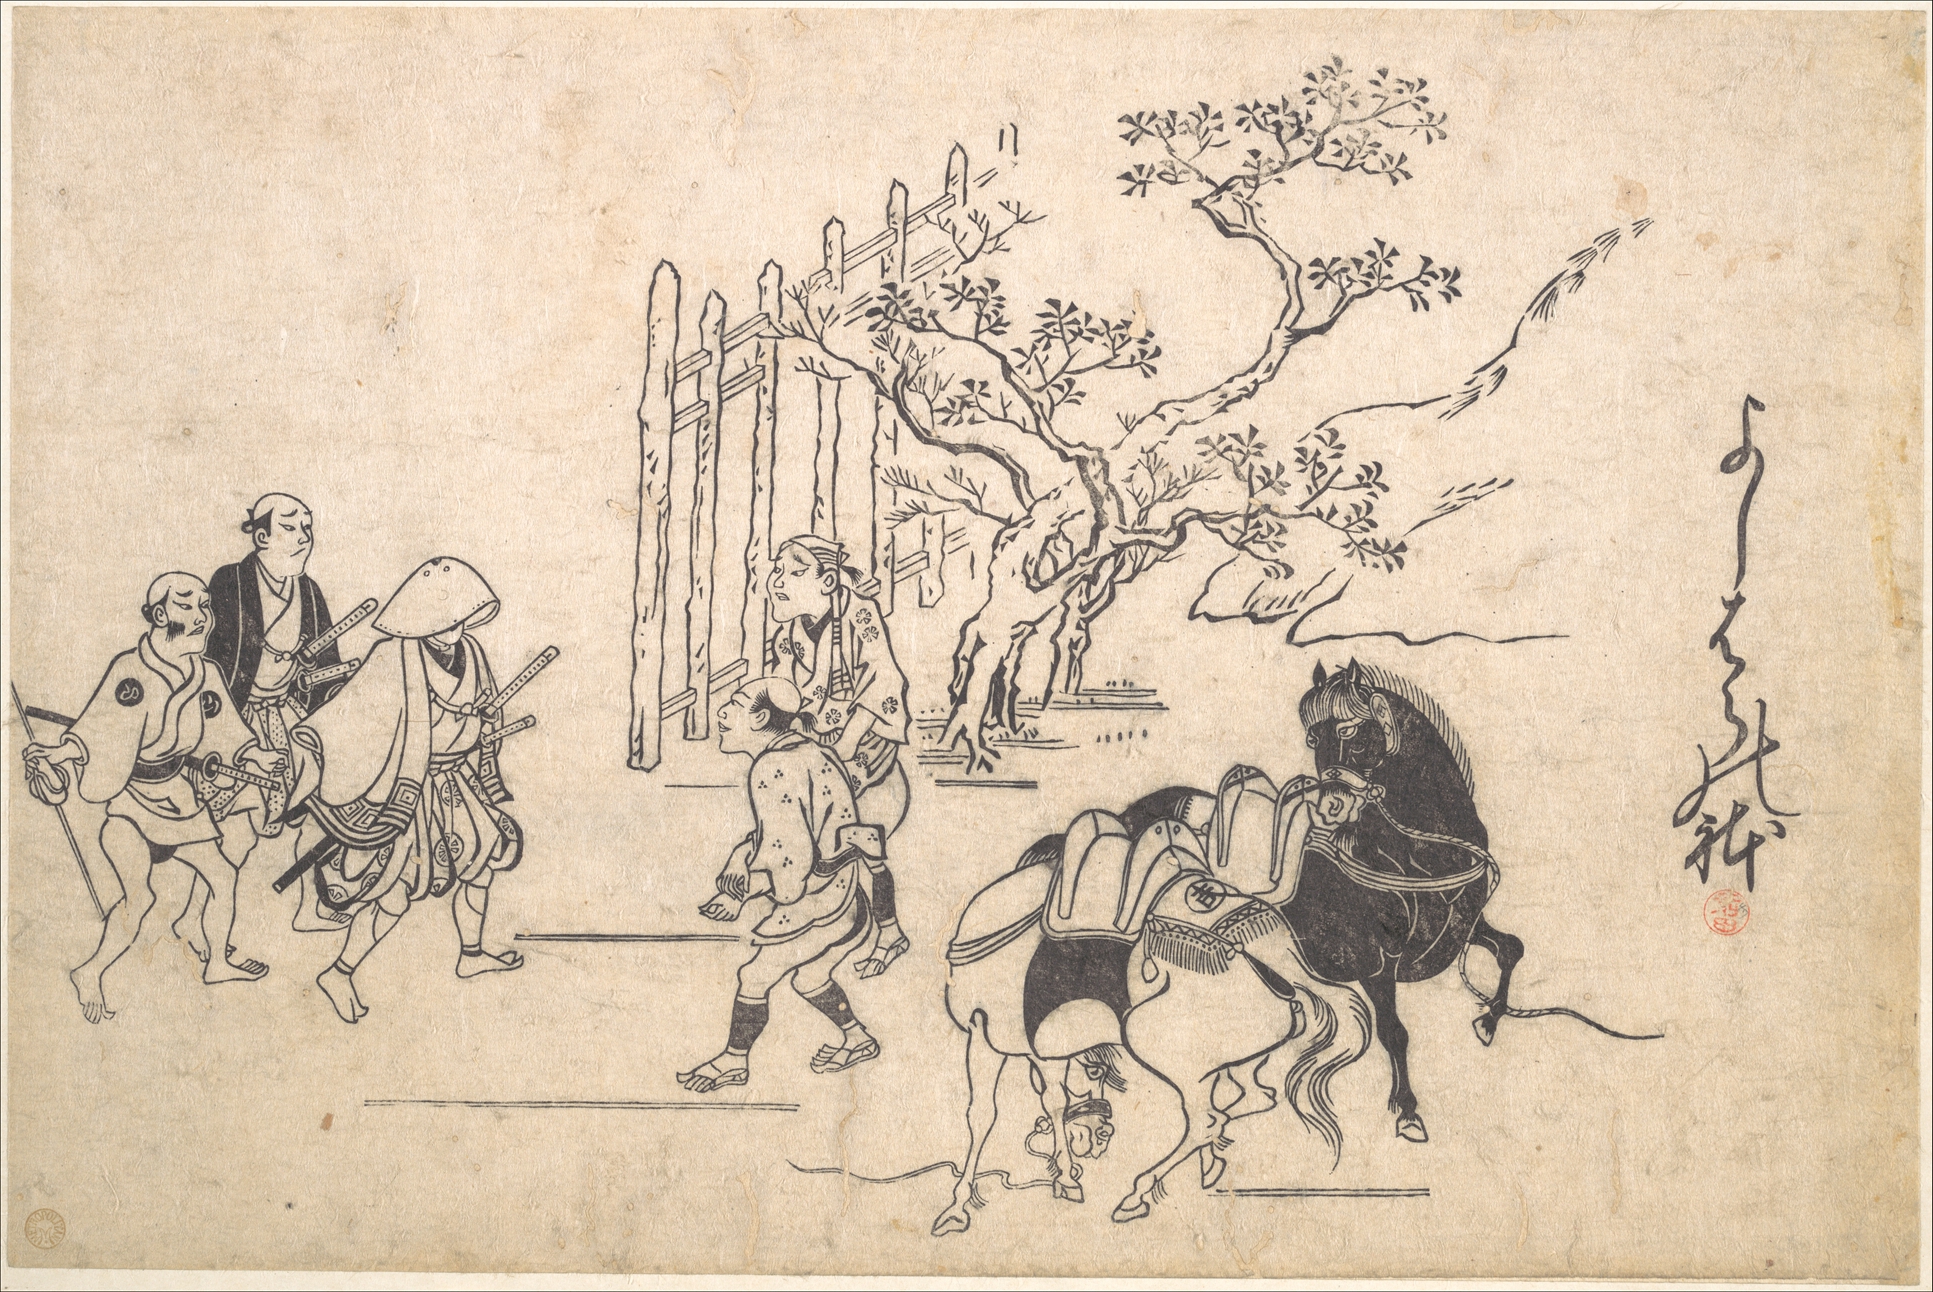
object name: print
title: Two Young Samurai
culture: japanese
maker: hishikawa moronobu 菱川師宣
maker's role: artist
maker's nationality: japanese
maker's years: 1618-1694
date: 1680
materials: ink, paper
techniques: woodblock print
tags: samurai,men,horses,trees